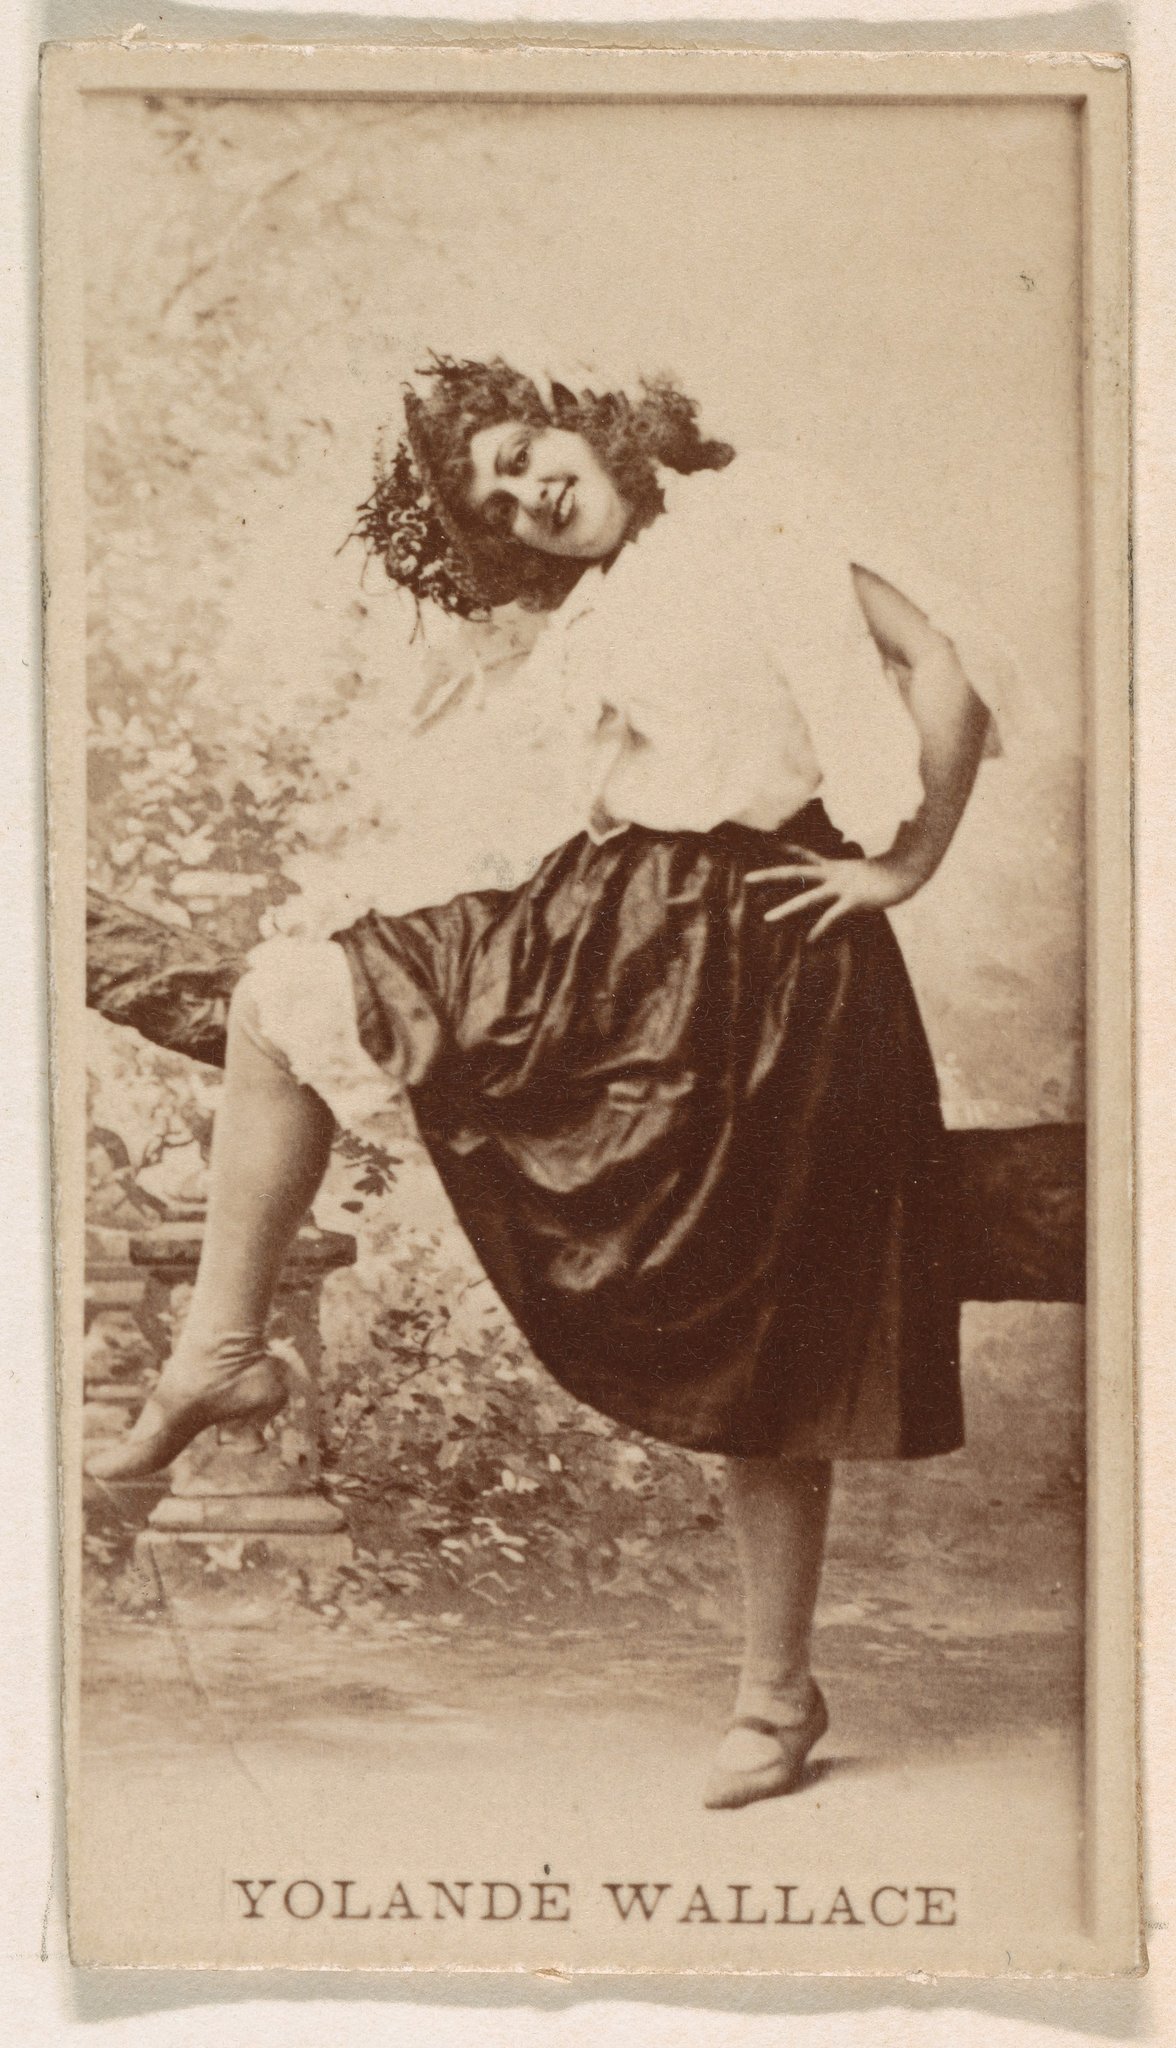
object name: photograph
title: Yolande Wallace, from the Actresses series (N245) issued by Kinney Brothers to promote Sweet Caporal Cigarettes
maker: kinney brothers tobacco company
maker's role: publisher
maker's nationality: american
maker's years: 1869-2011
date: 1890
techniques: albumen silver print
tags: portraits,women,actresses